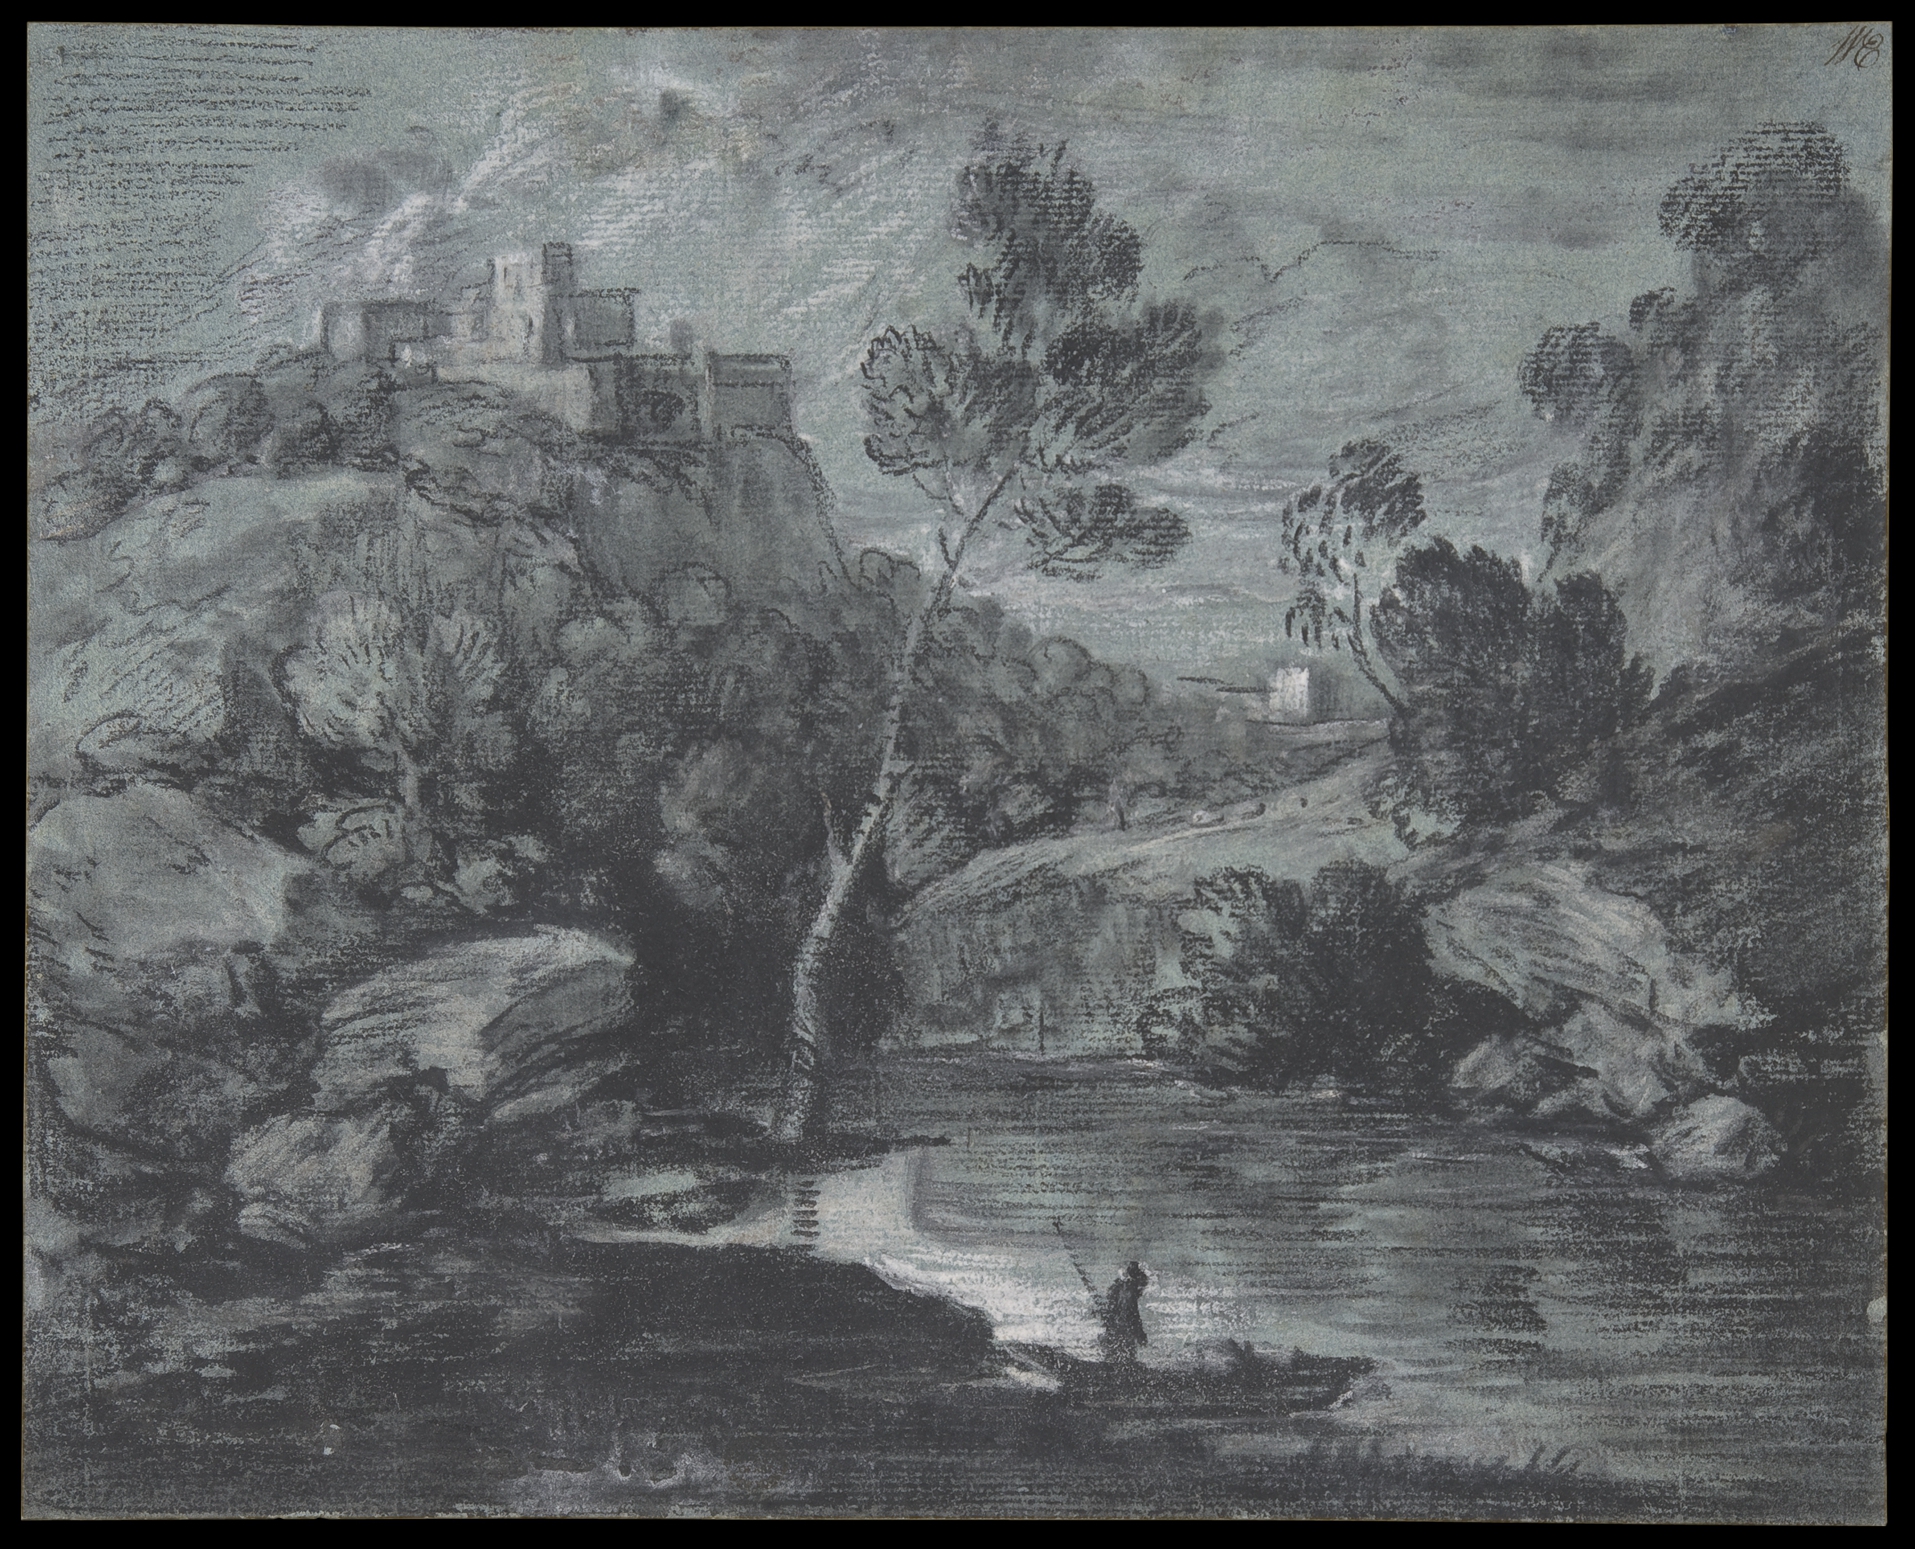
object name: drawing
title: Mountain Landscape with a Castle and a Boatman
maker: thomas gainsborough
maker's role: artist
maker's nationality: british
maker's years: 1727-1788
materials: chalk, paper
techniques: stumping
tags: castles,mountains,landscapes,boats